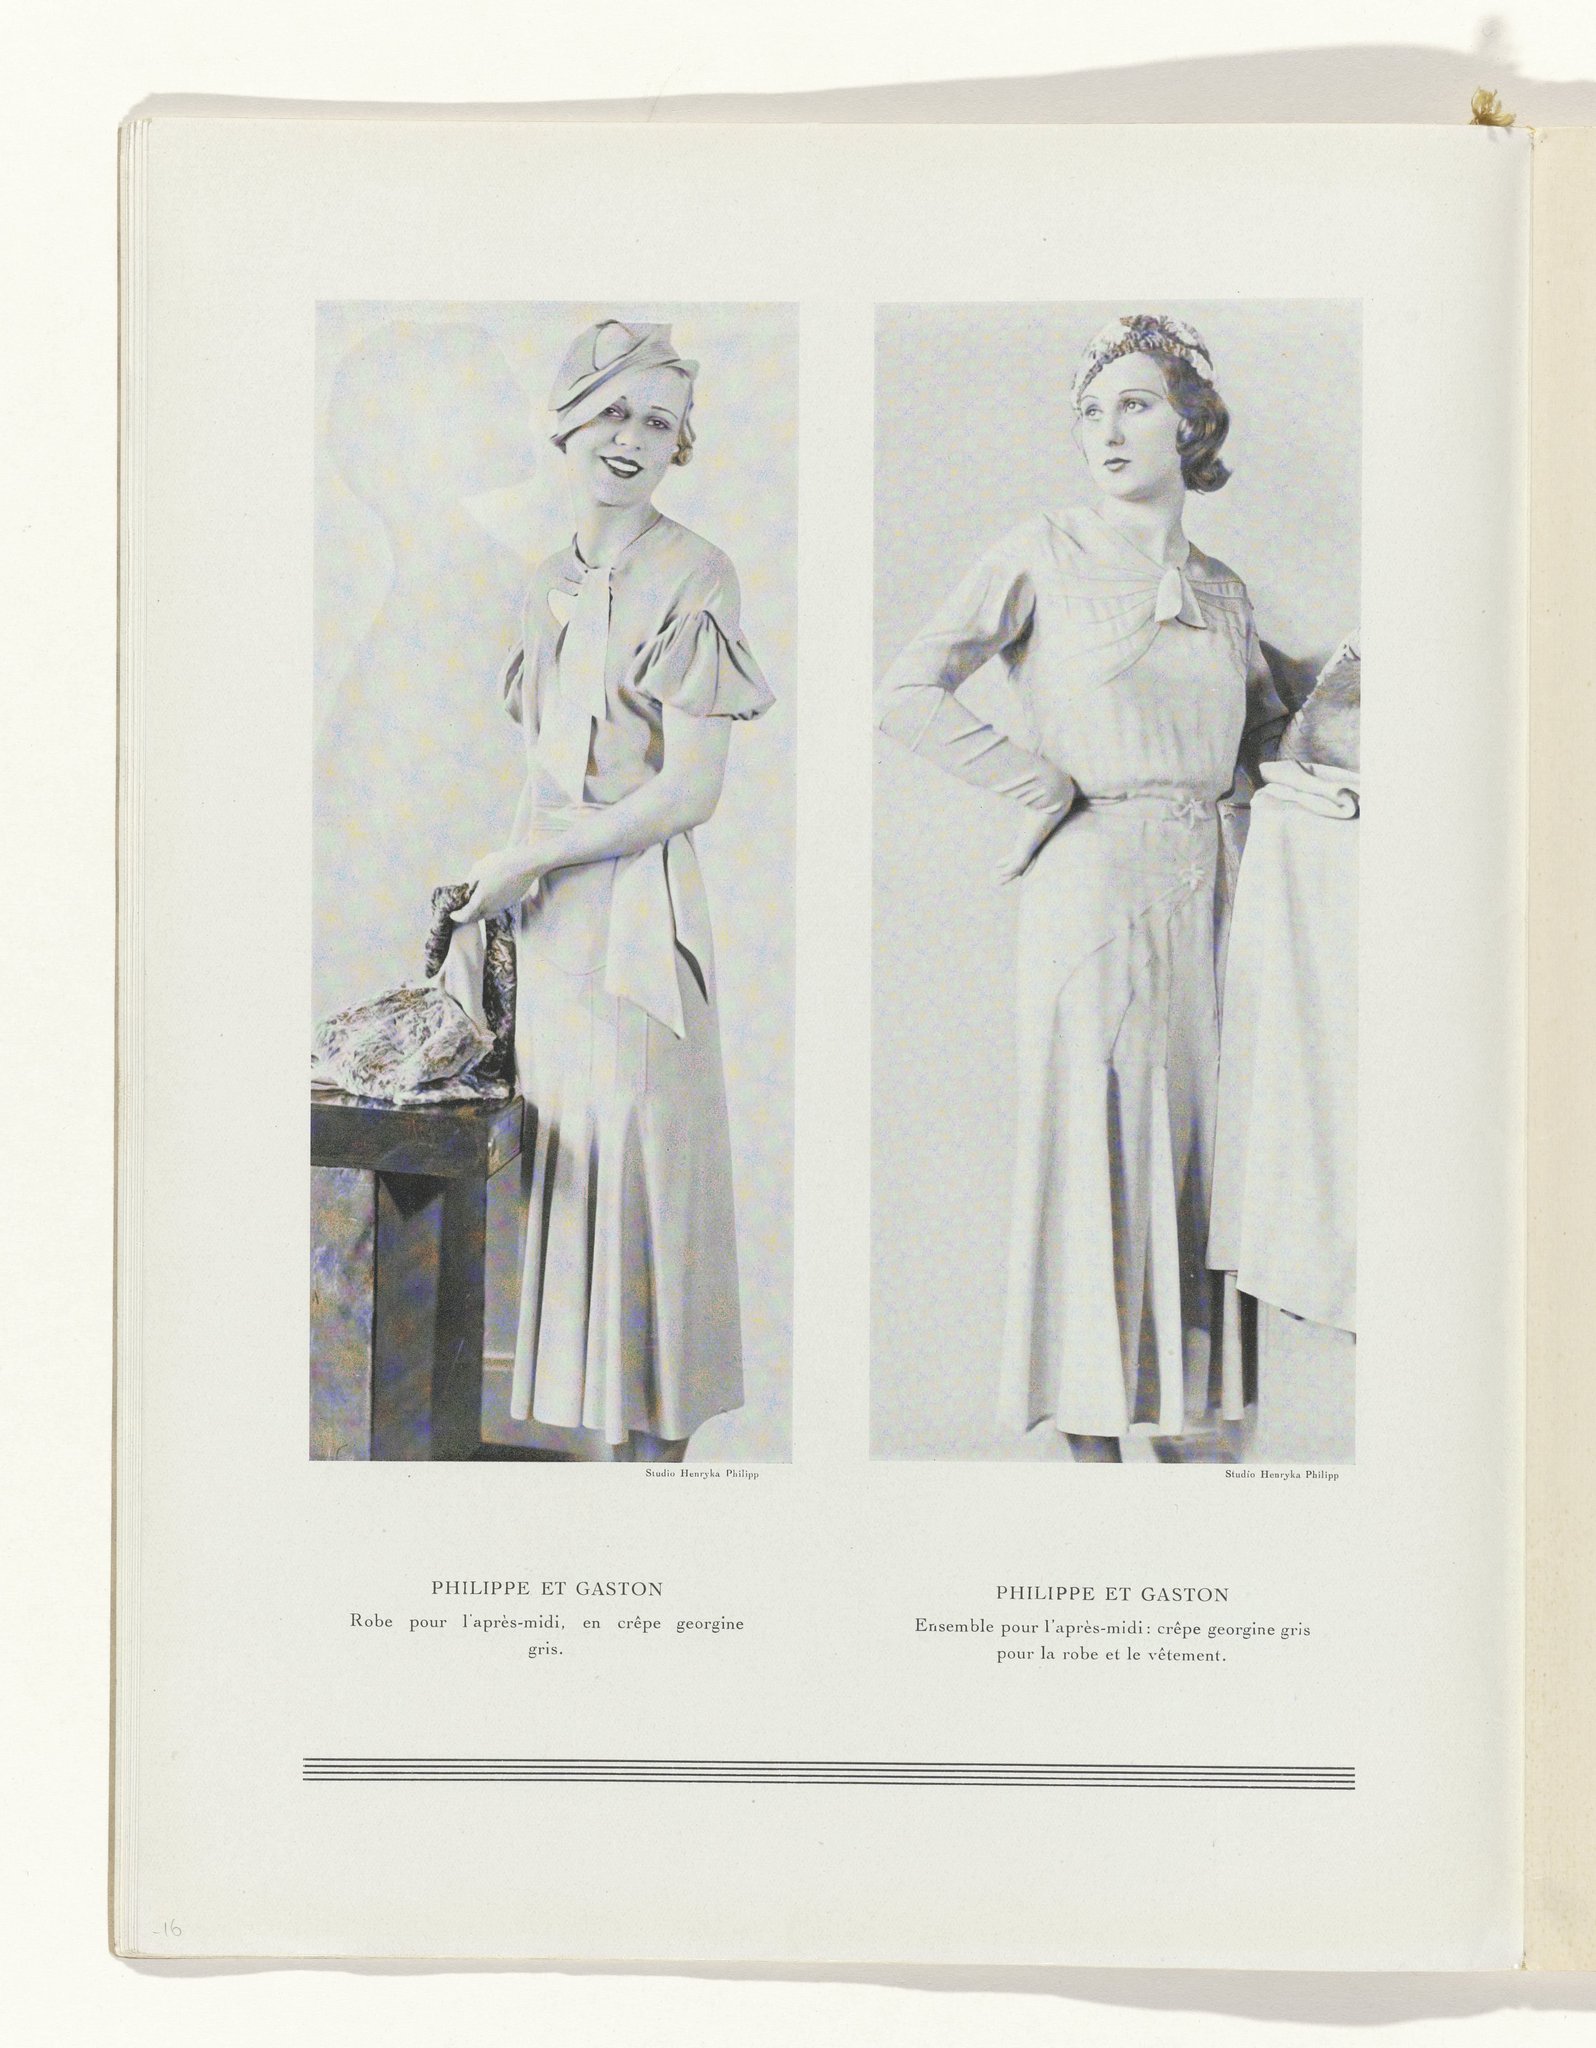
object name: fashion print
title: Art - Goût - Beauté, Feuillets de l' élégance féminine, Juin 1932, No. 142, 12e Année, p. 16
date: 1932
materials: paper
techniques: photography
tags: dress, gown: day dress (+ women's clothes), fashion plates, head-gear: hat (+ women's clothes)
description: Middagjaponnen van Philippe et Gaston. Links: middagjapon van grijze crêpe georgine. Rechts: ensemble voor de middag van grijze crêpe georgine. Pagina uit het modetijdschrift Art-Goût-Beauté (1920-1933).